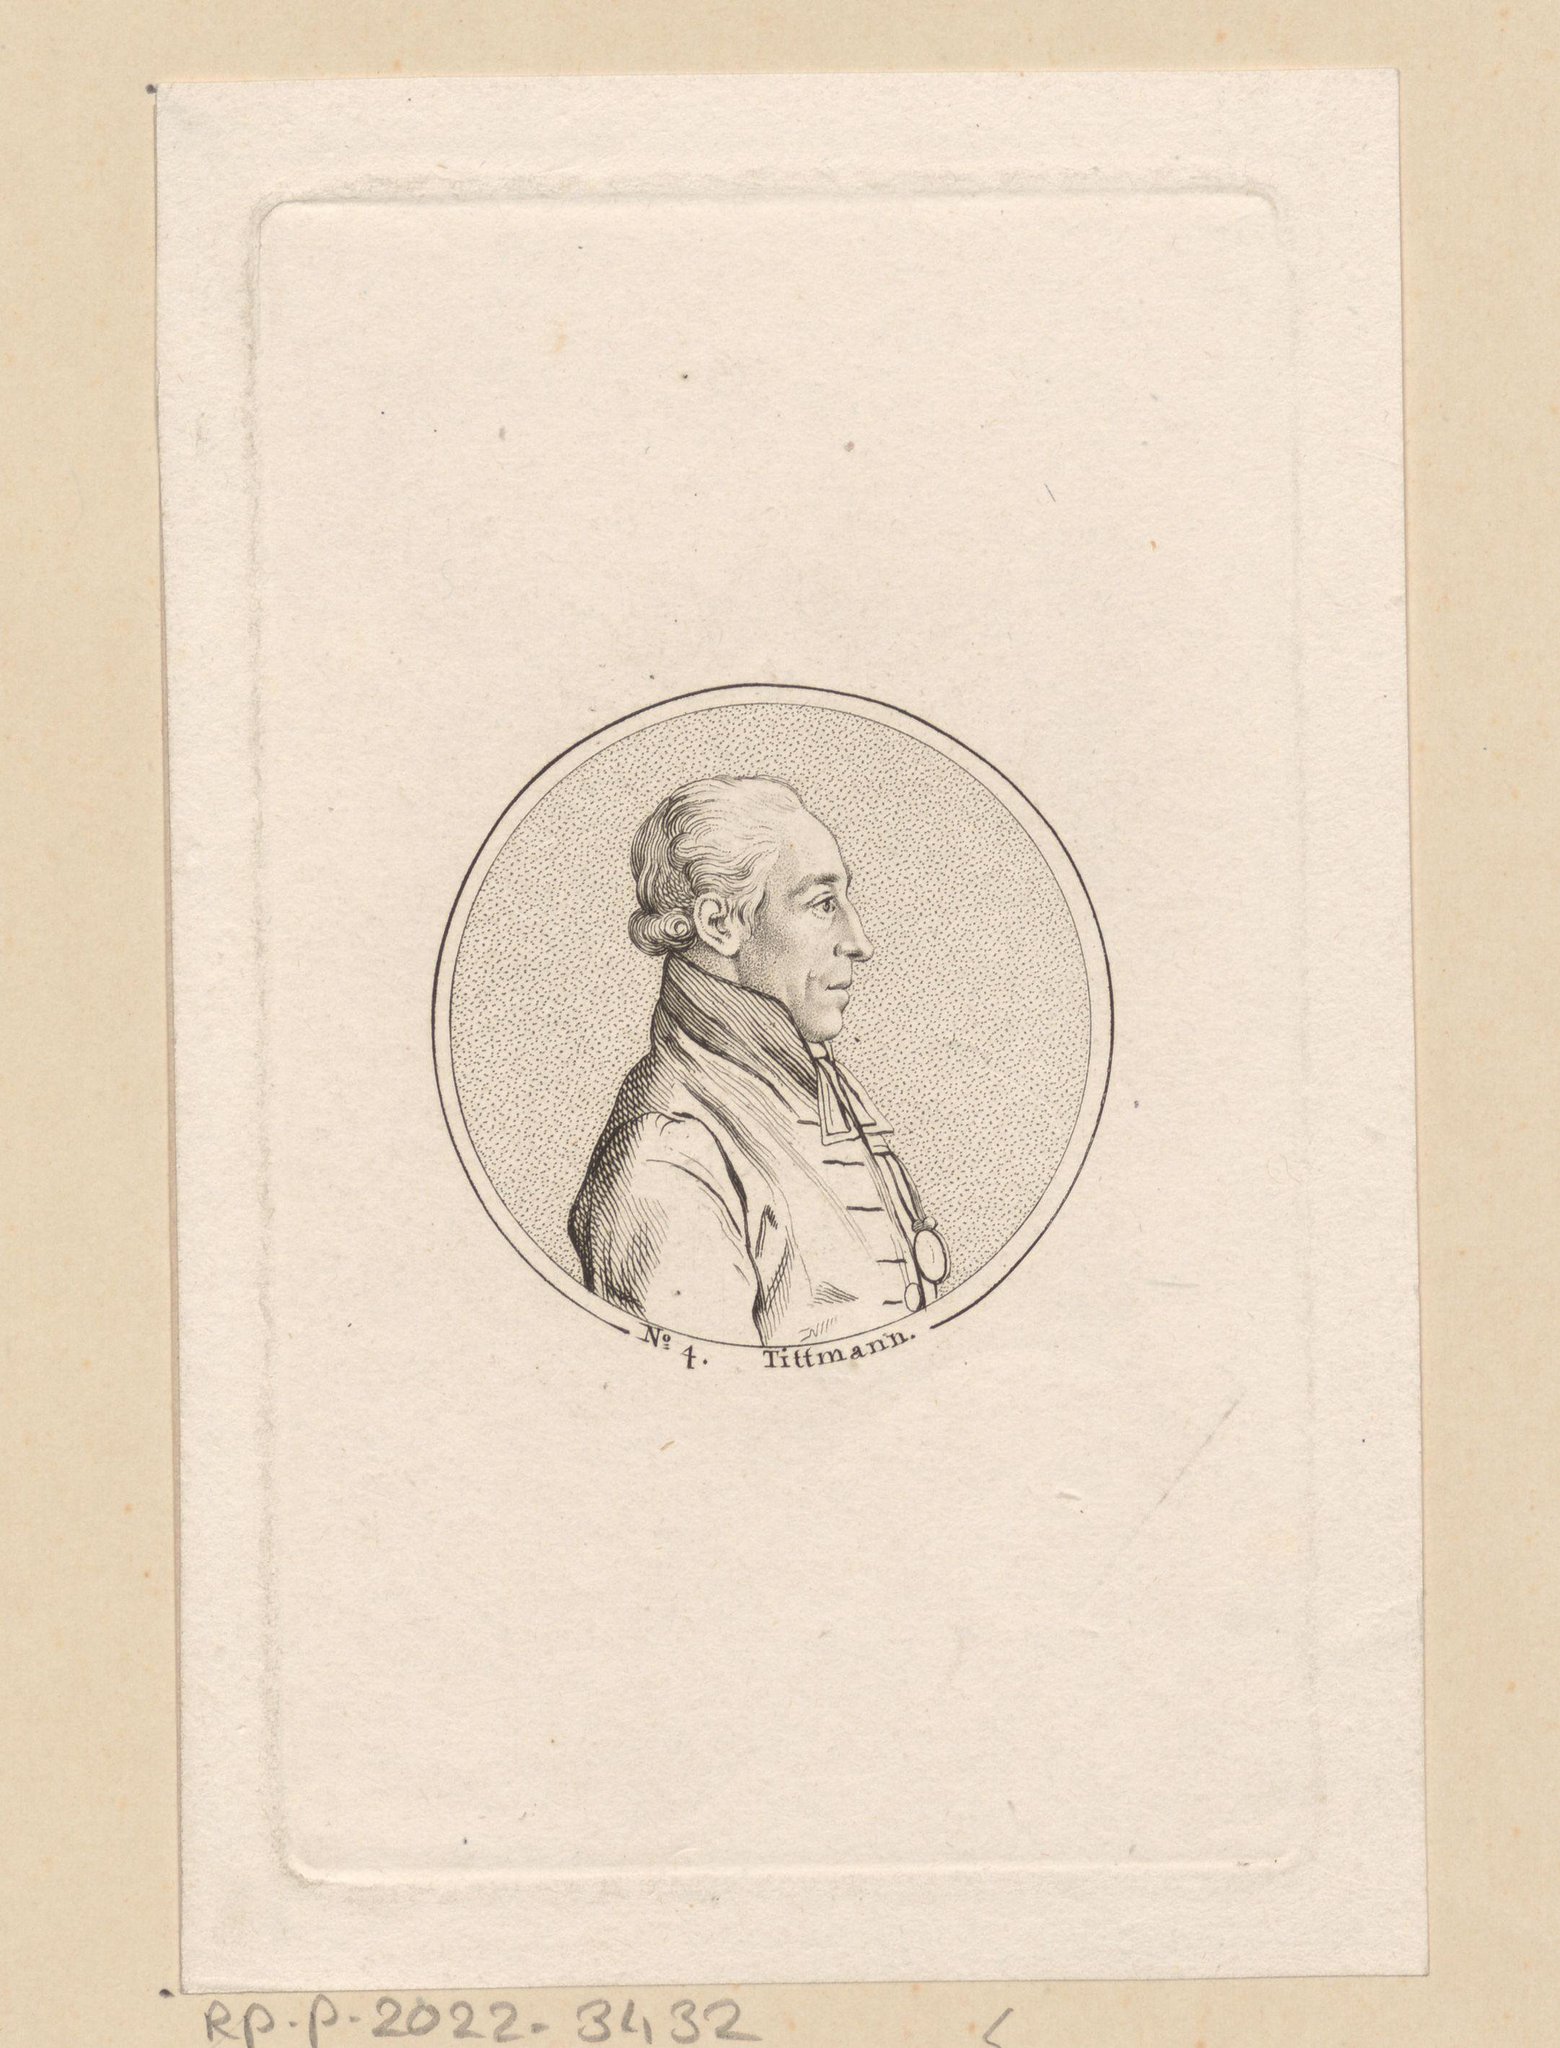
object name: print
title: Portret van Johann August Heinrich Tittmann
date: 1810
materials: paper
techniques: etching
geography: germany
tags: theologian, historical persons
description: Prent waarschijnlijk uit: Kreussler, Heinrich Gottlieb. Autobiographieen Leipziger Gelehrten. Leipzig: J.B. Fleischer, 1810, p. 16-17.